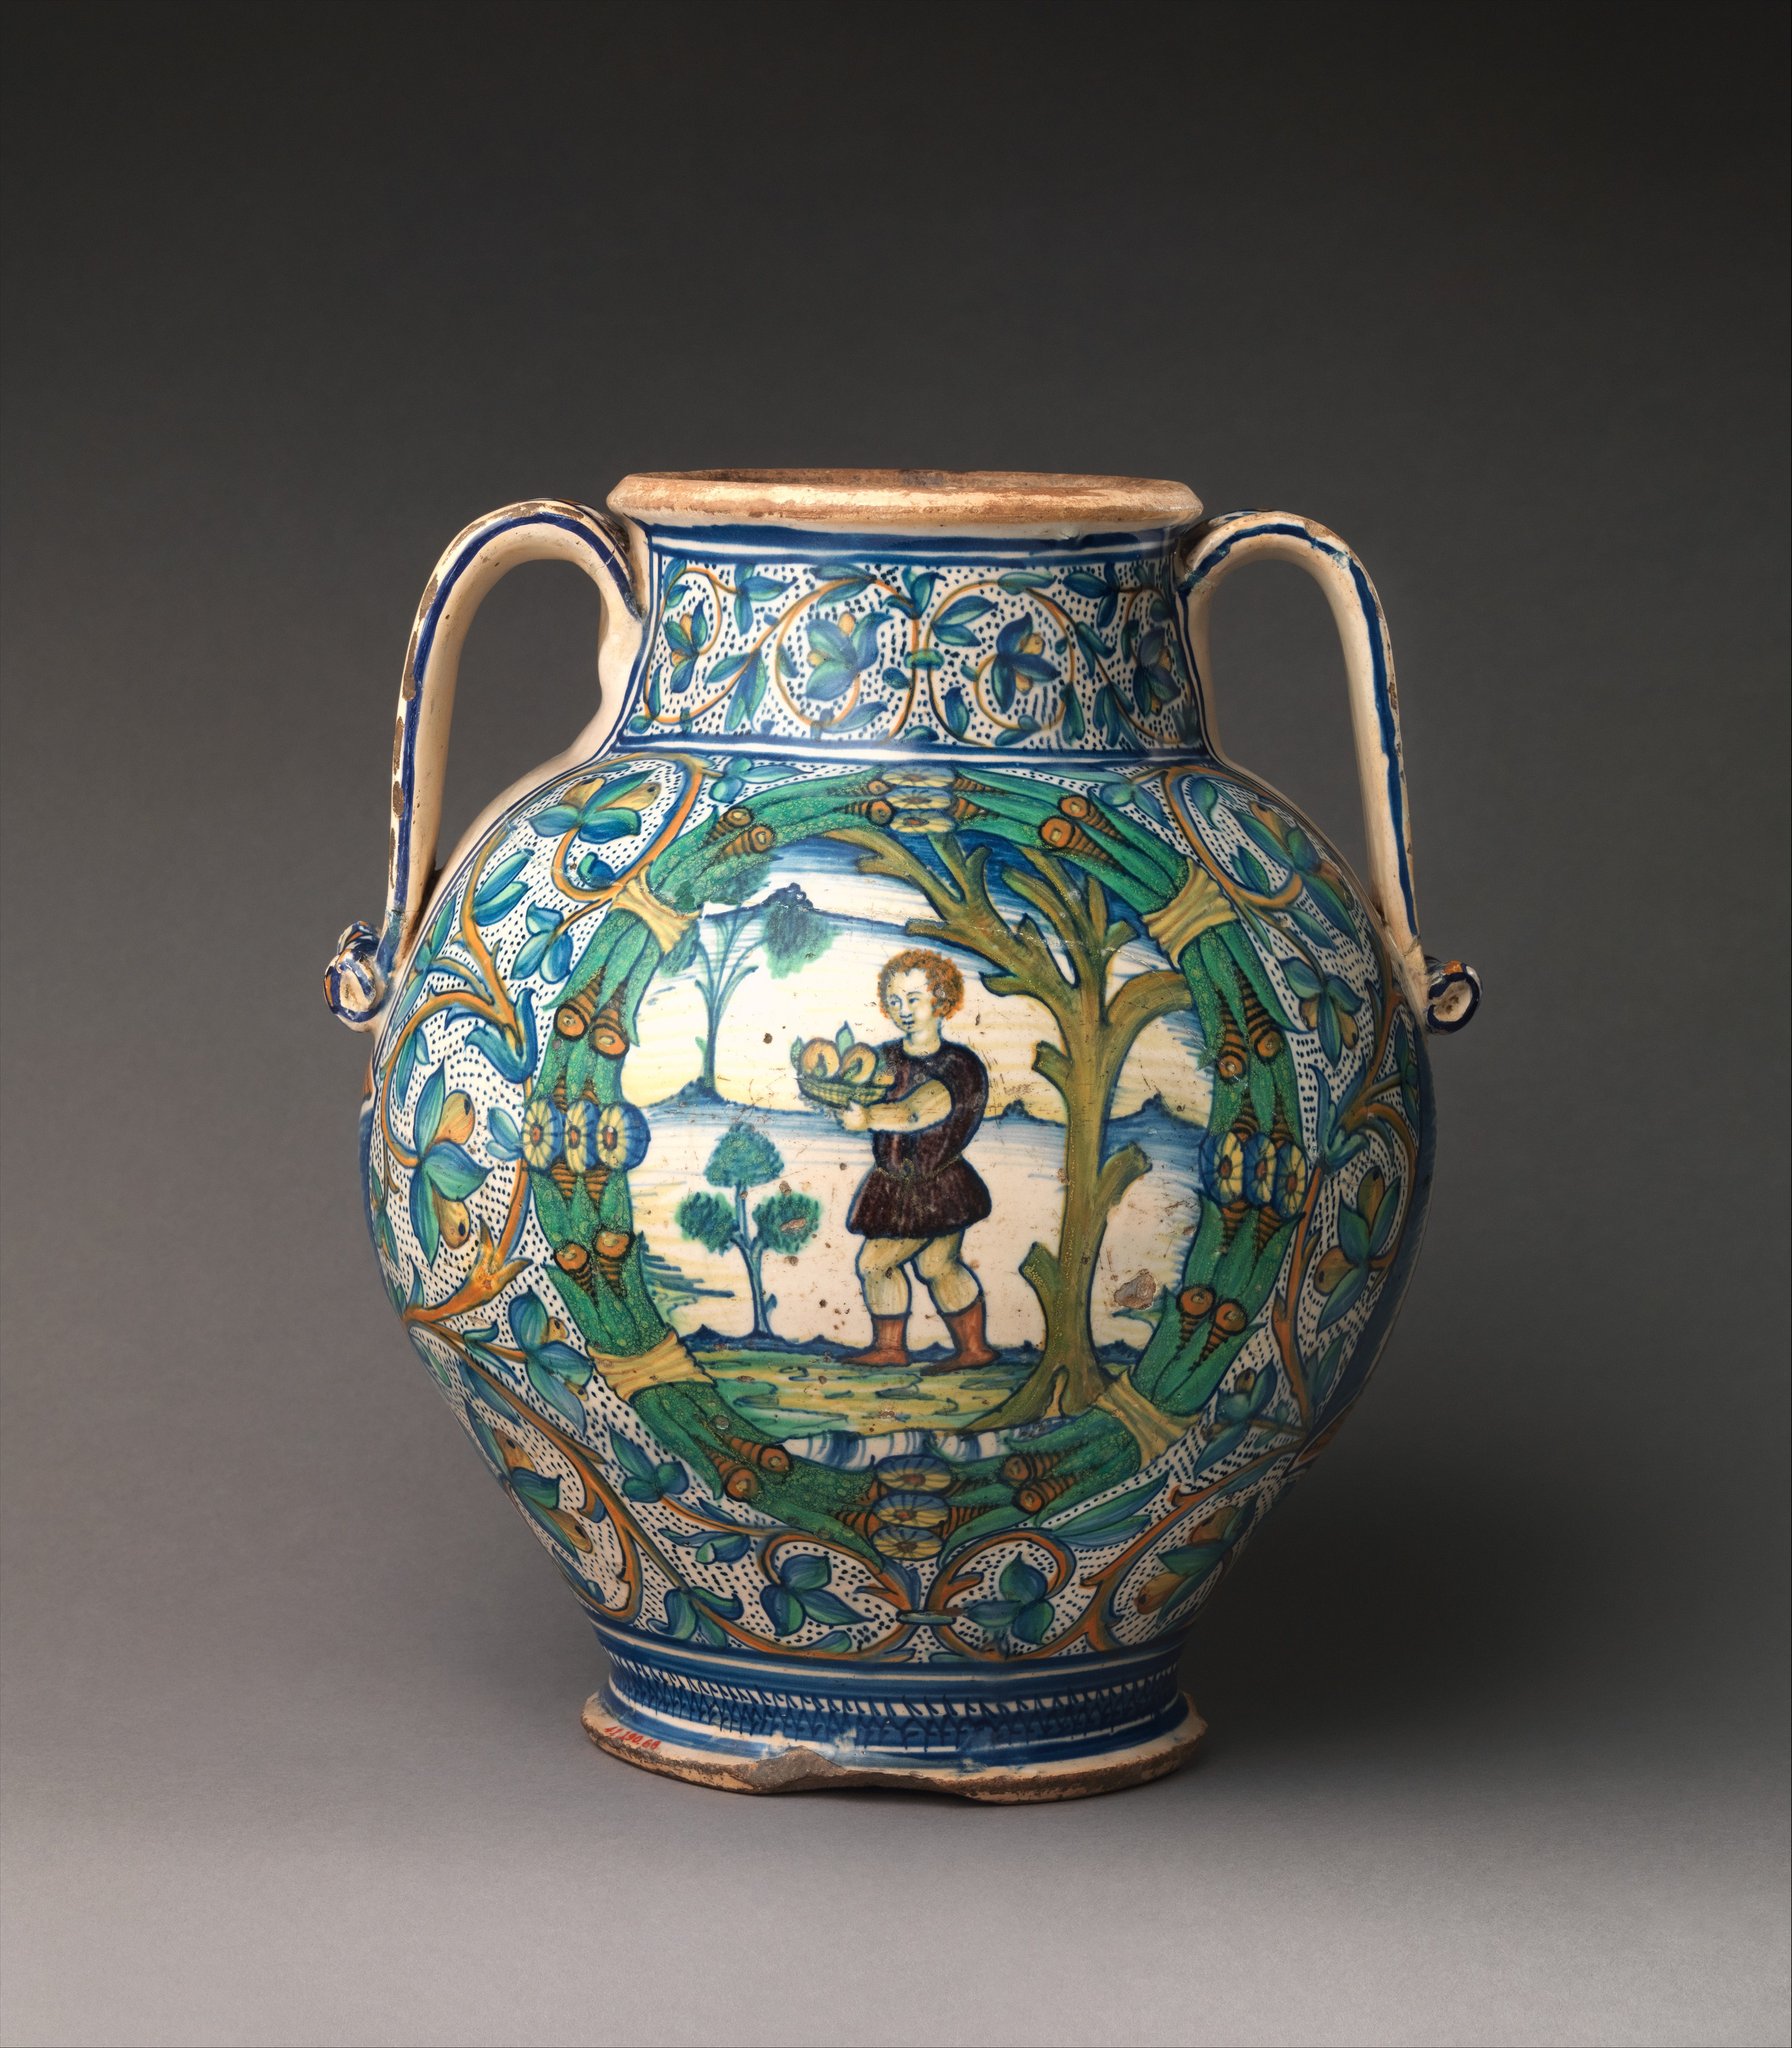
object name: storage or pharmacy jar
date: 1500-1520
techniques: maiolica, glazing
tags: boys